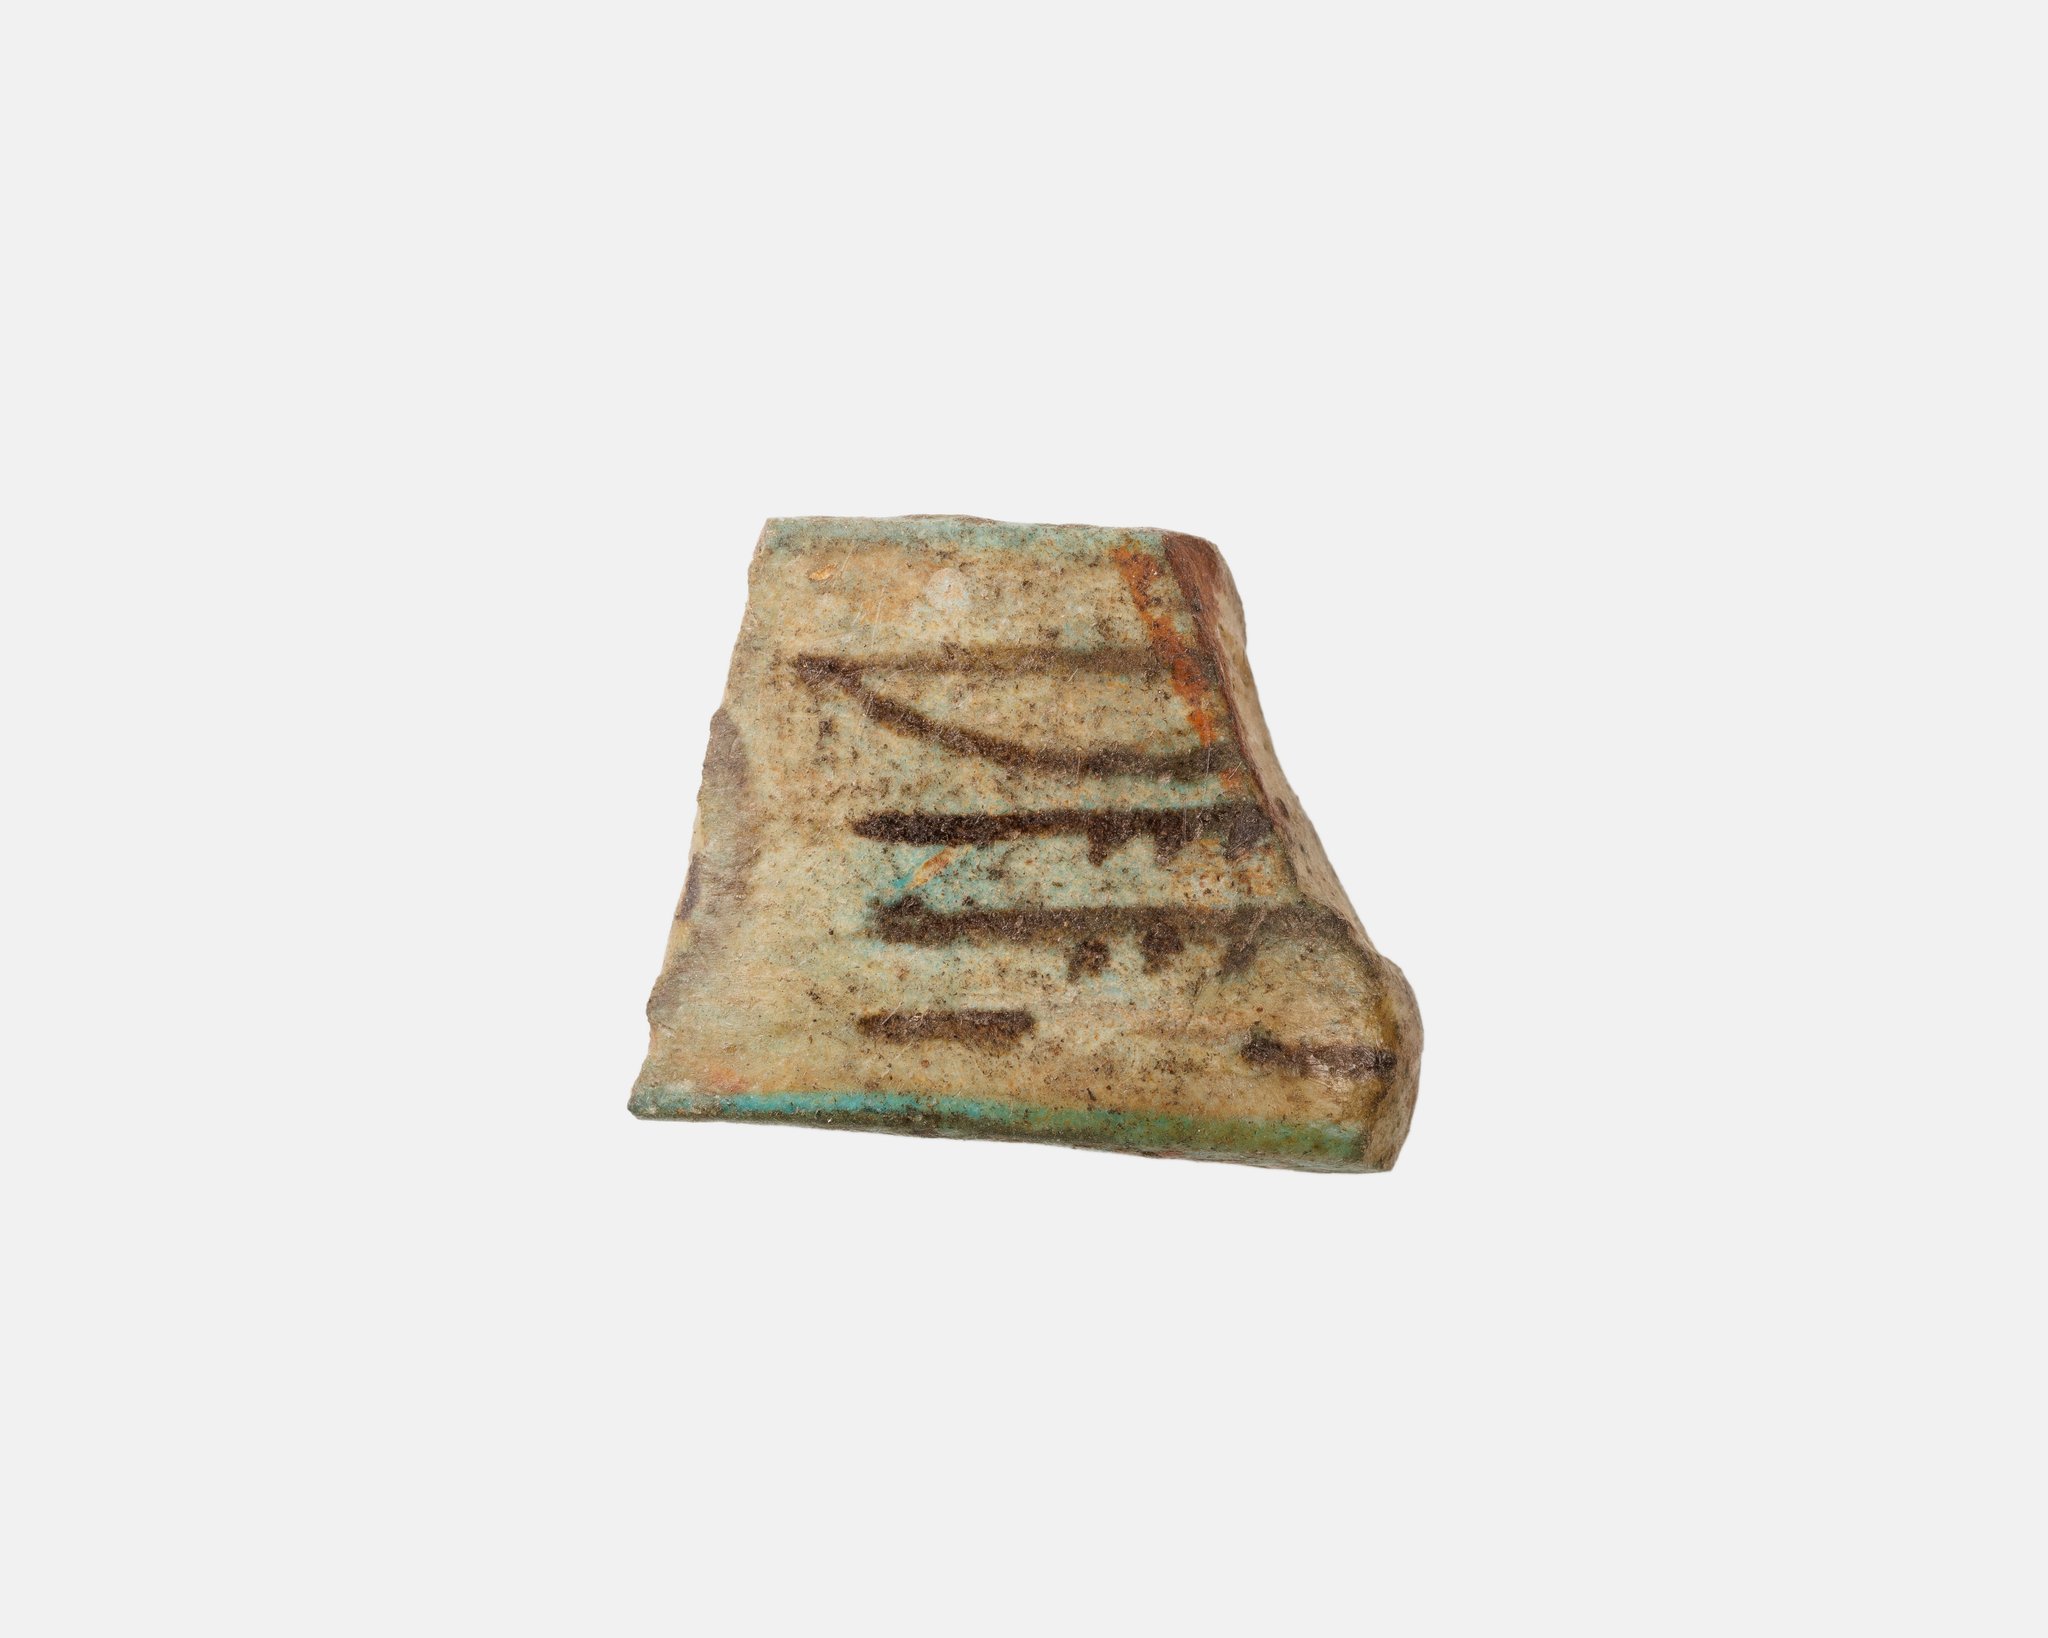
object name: votive bracelet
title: Fragment of a votive bracelet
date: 1295-1070 BCE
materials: faience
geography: egypt